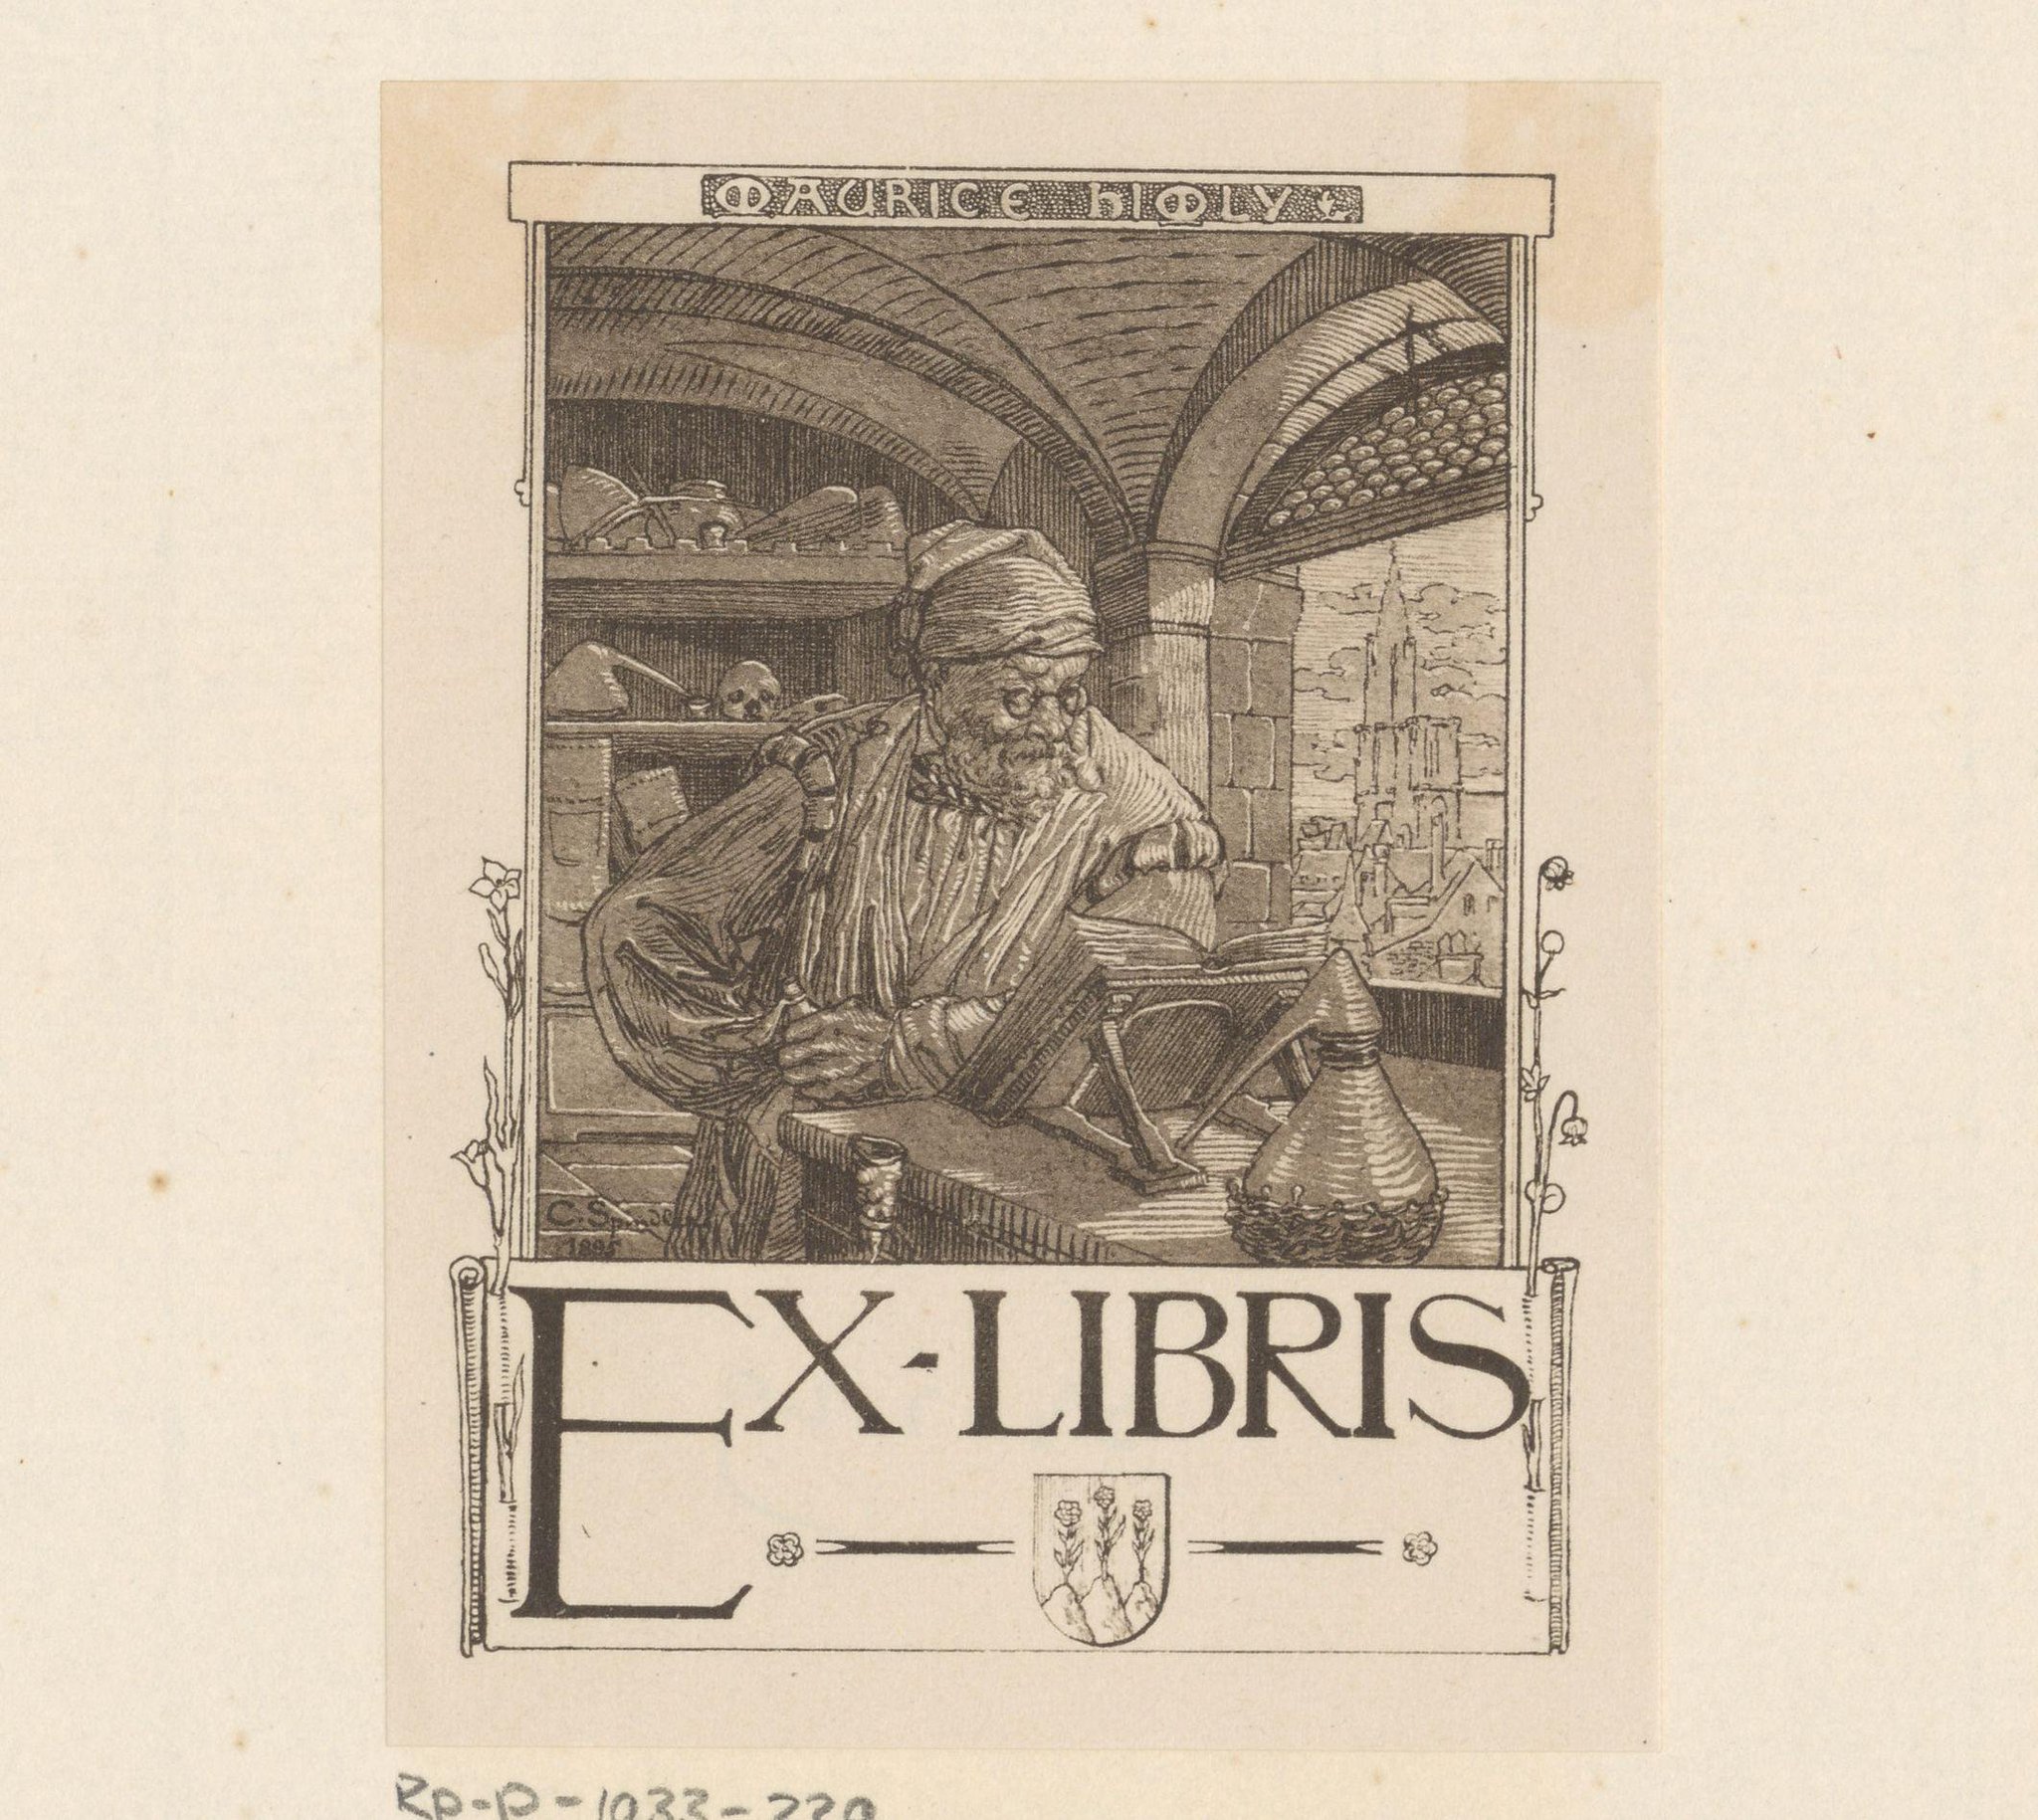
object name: bookplate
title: Ex libris van Maurice Himly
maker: Anonymous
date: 1868-1899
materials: paper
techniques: photograph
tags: pharmacist, druggist, apothecary; pharmacy, drugstore, dispensing chemist, laboratory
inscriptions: collector's mark: Lugt 2760